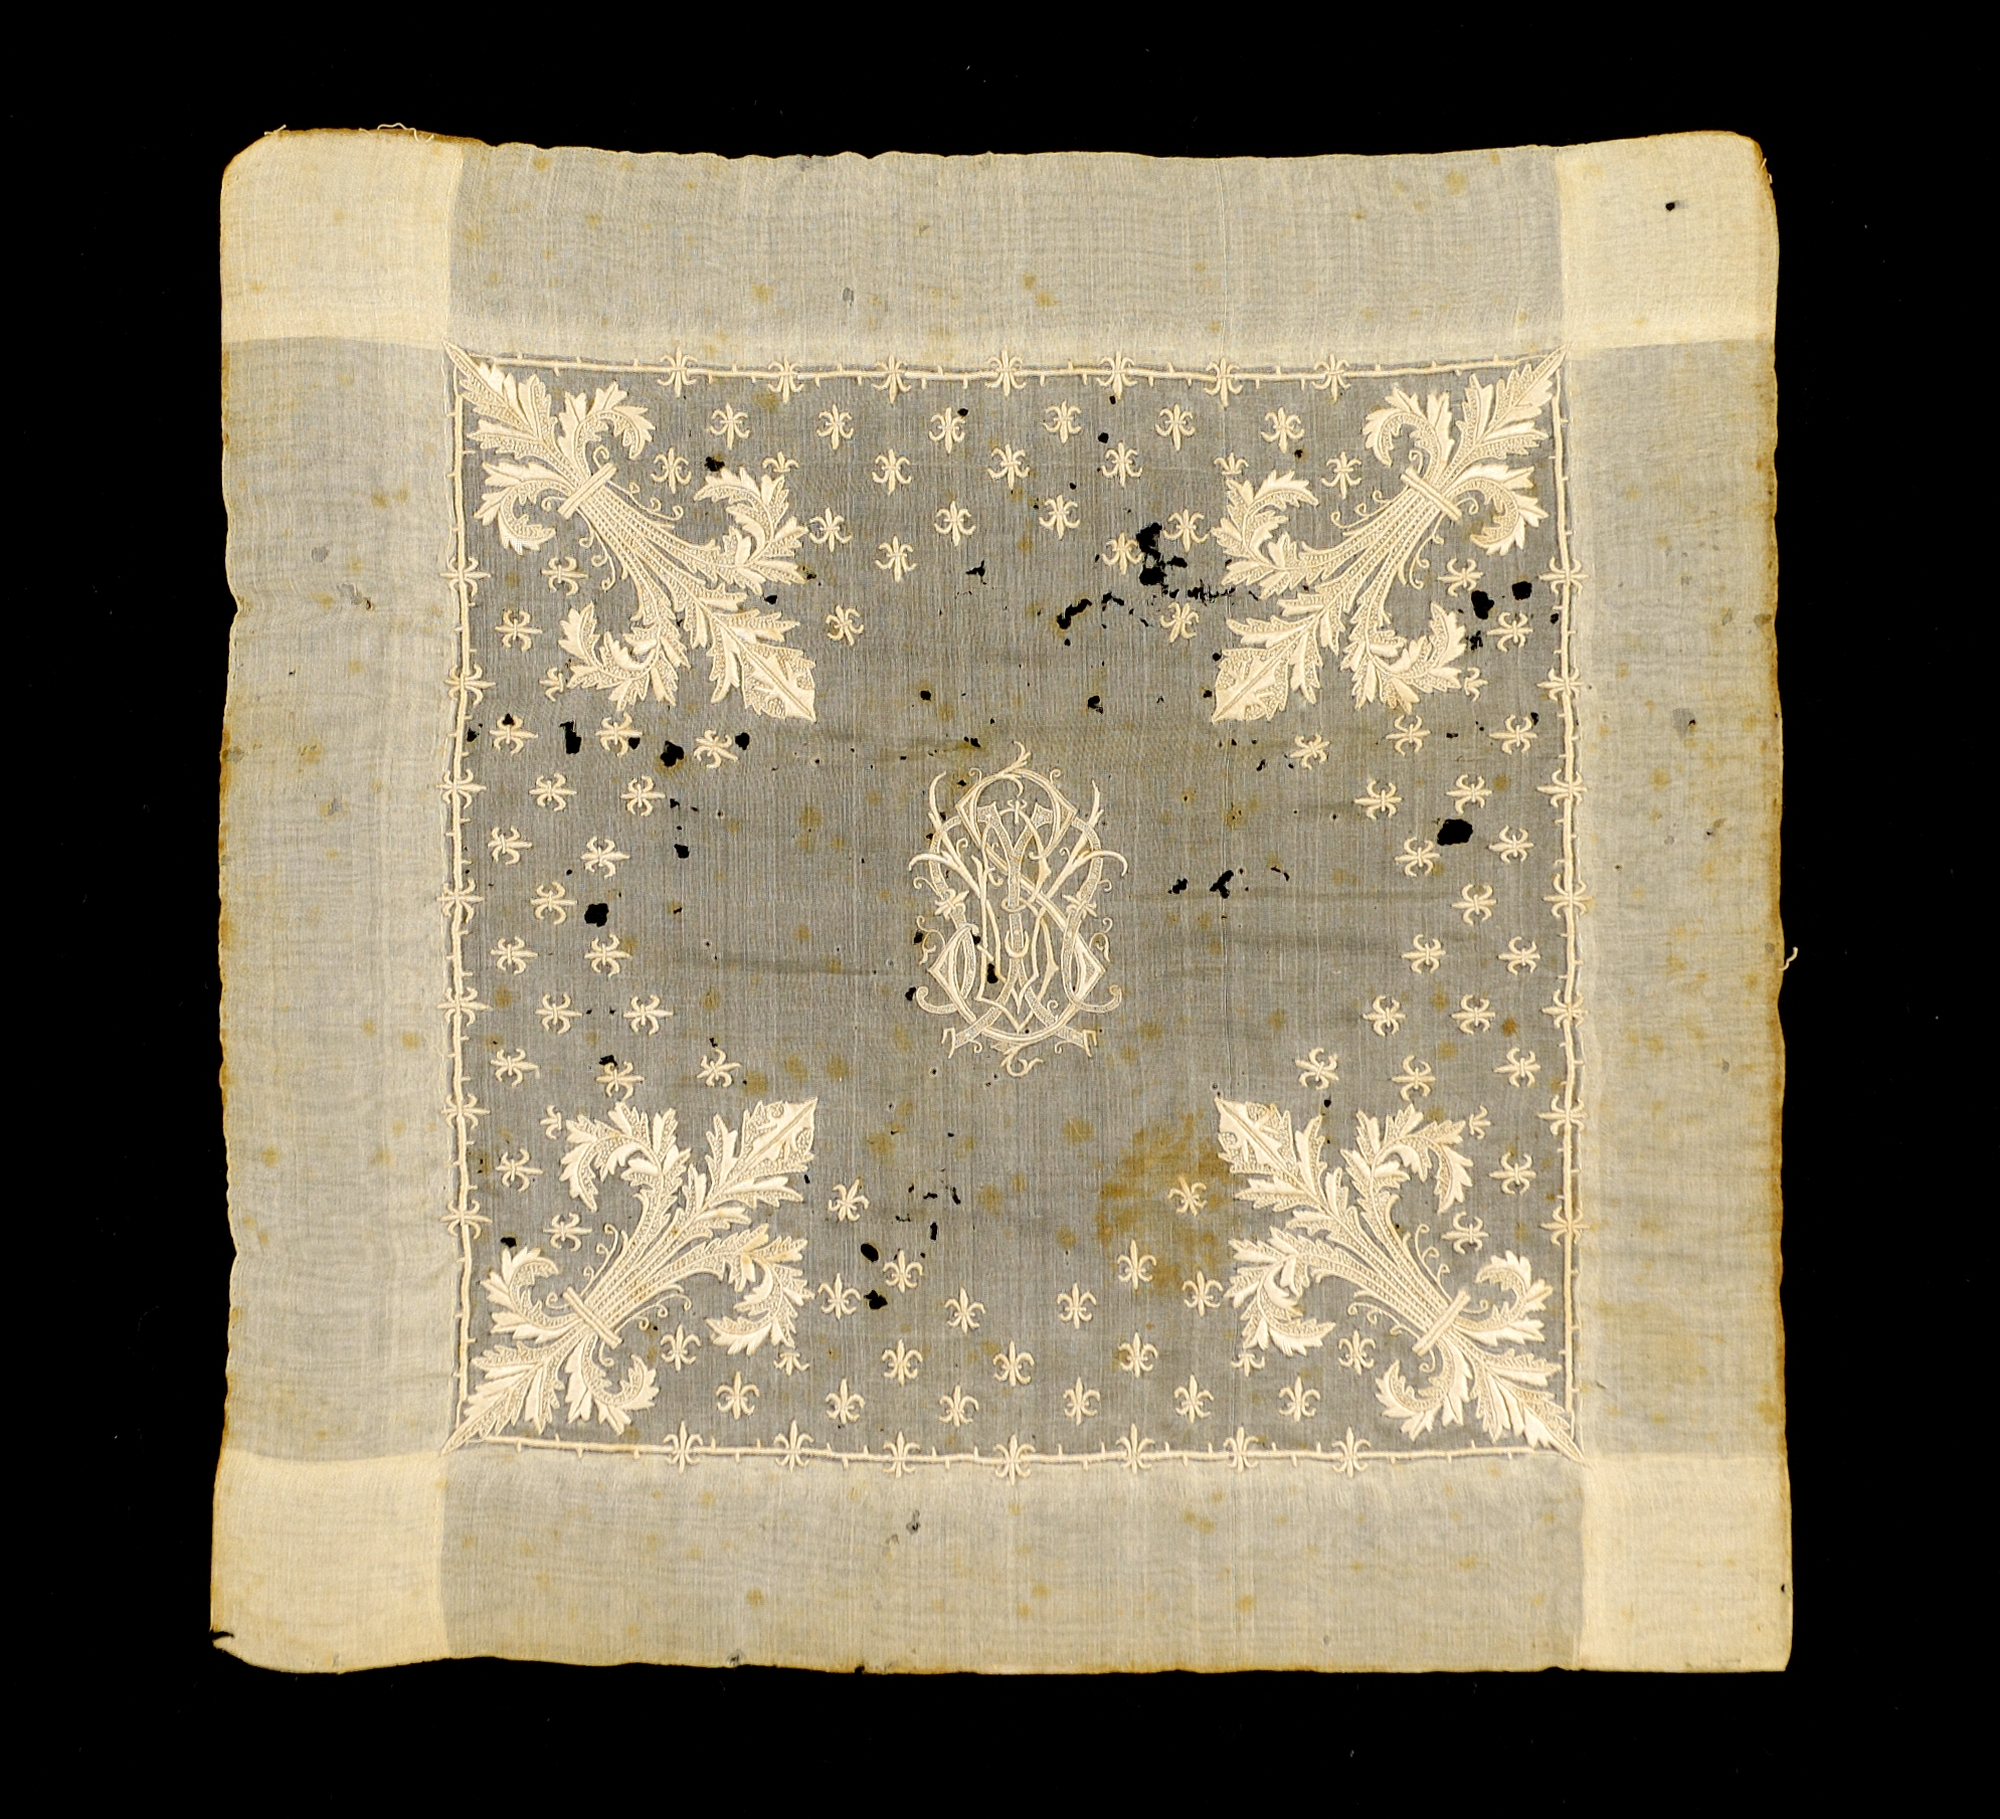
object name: wedding handkerchief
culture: american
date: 1855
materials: cotton